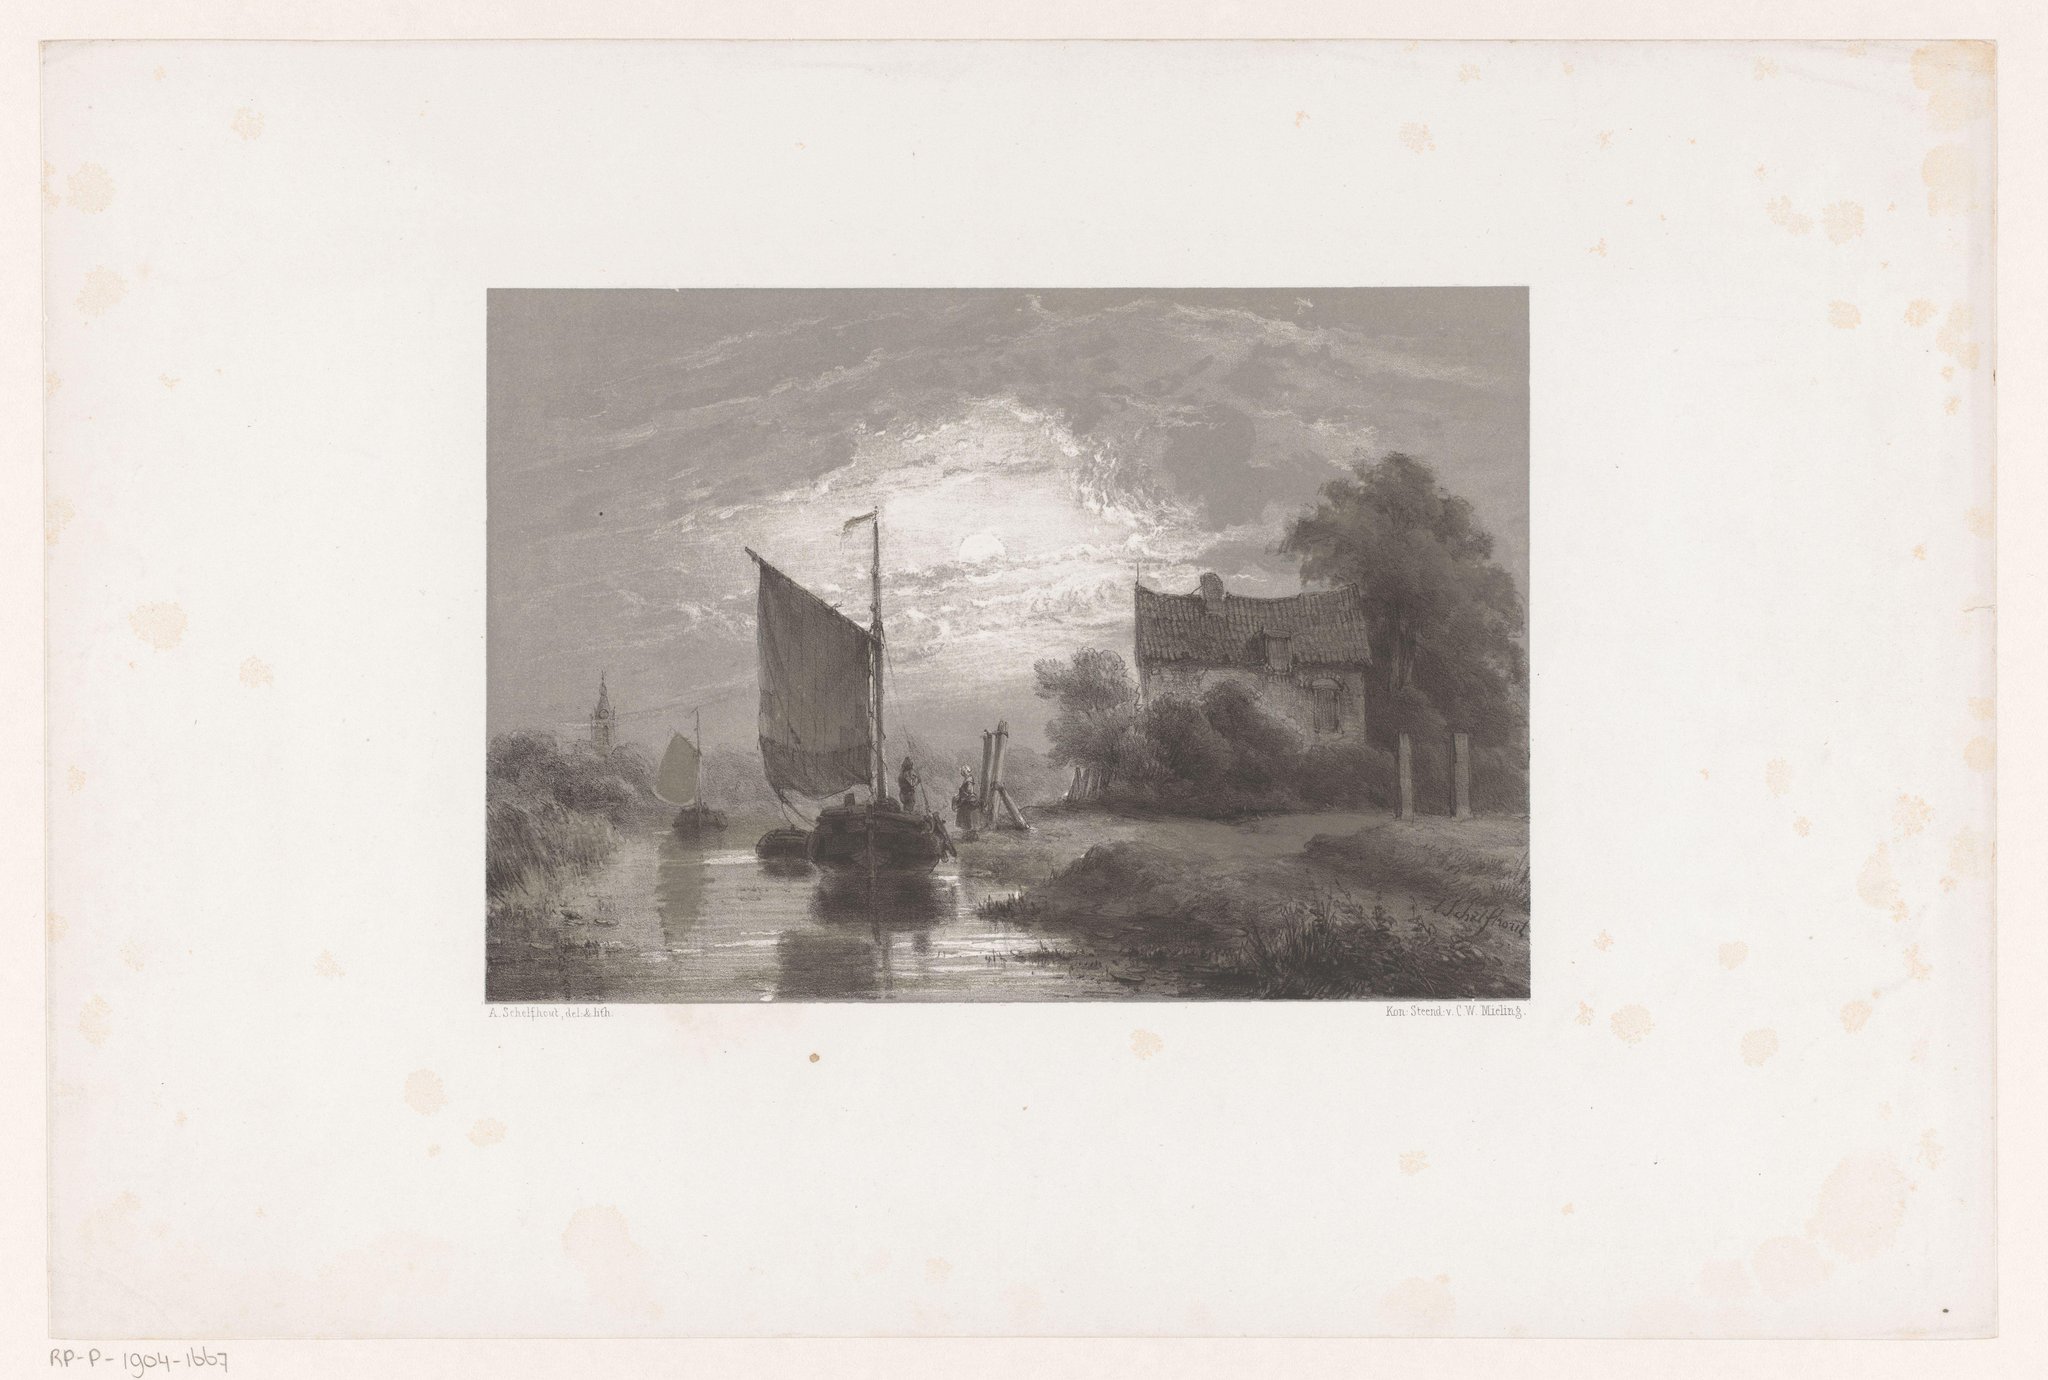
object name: print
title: De Hollandsche Schilderschool / Het Hollandsche Schilder- en Letterkundig Album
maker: andreas schelfhout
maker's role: draughtsman, painter, print maker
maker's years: 1787-1870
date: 1847-1848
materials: paper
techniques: tone lithography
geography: the hague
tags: sailing-ship, sailing-boat, conversation, dialogue; conversation piece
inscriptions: collector's mark: Lugt 2228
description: Uitgegeven als onderdeel van de prentserie 'De Hollandsche Schilderschool. Teekeningen en schetsen van de beroemdste schilders van Nederland, door hun zelven op steen geteekend', die in 1847 te Den Haag werd uitgegeven door C.W. Mieling. In 1848 werd de serie opnieuw uitgegeven onder de titel 'Het Hollandsche Schilder- en Letterkundig Album. Verzameling van oorspronkelijke steenteekeningen en letterkundige voortbrengselen der beroemde schilders en letterkundigen'. Uitgever Mieling verkreeg in 1847 het predicaat 'koninklijk'. Gezien die vermelding op de eerdere staat ontbreekt (zie RP-P-1880-A-4083 en RP-P-1904-1666), is het waarschijnlijk dat die eerste staat tot de uitgave van 1847 behoort en dat die in dat jaar nog vóór de toekenning van het koninklijke predicaat verscheen. De huidige staat behoort dan waarschijnlijk tot de tweede uitgave, uit 1848.